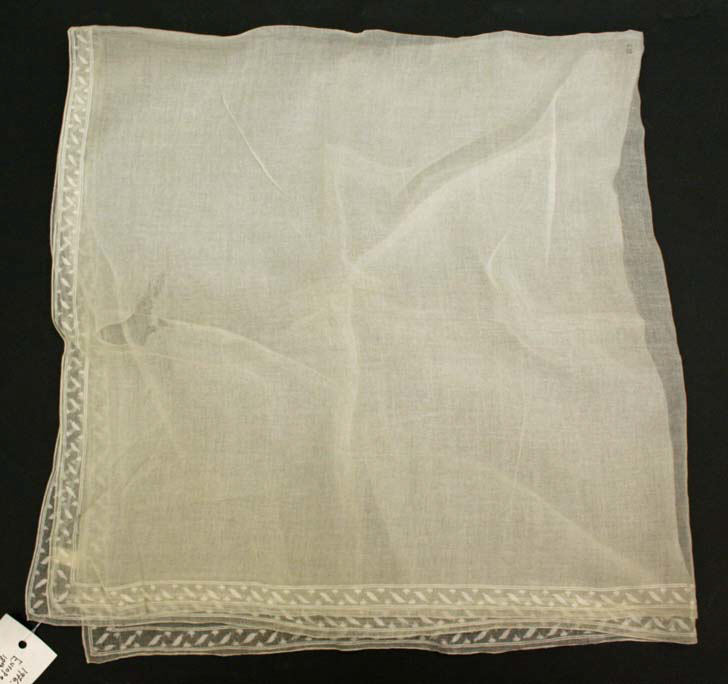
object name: kerchief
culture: european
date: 1701-1800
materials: cotton